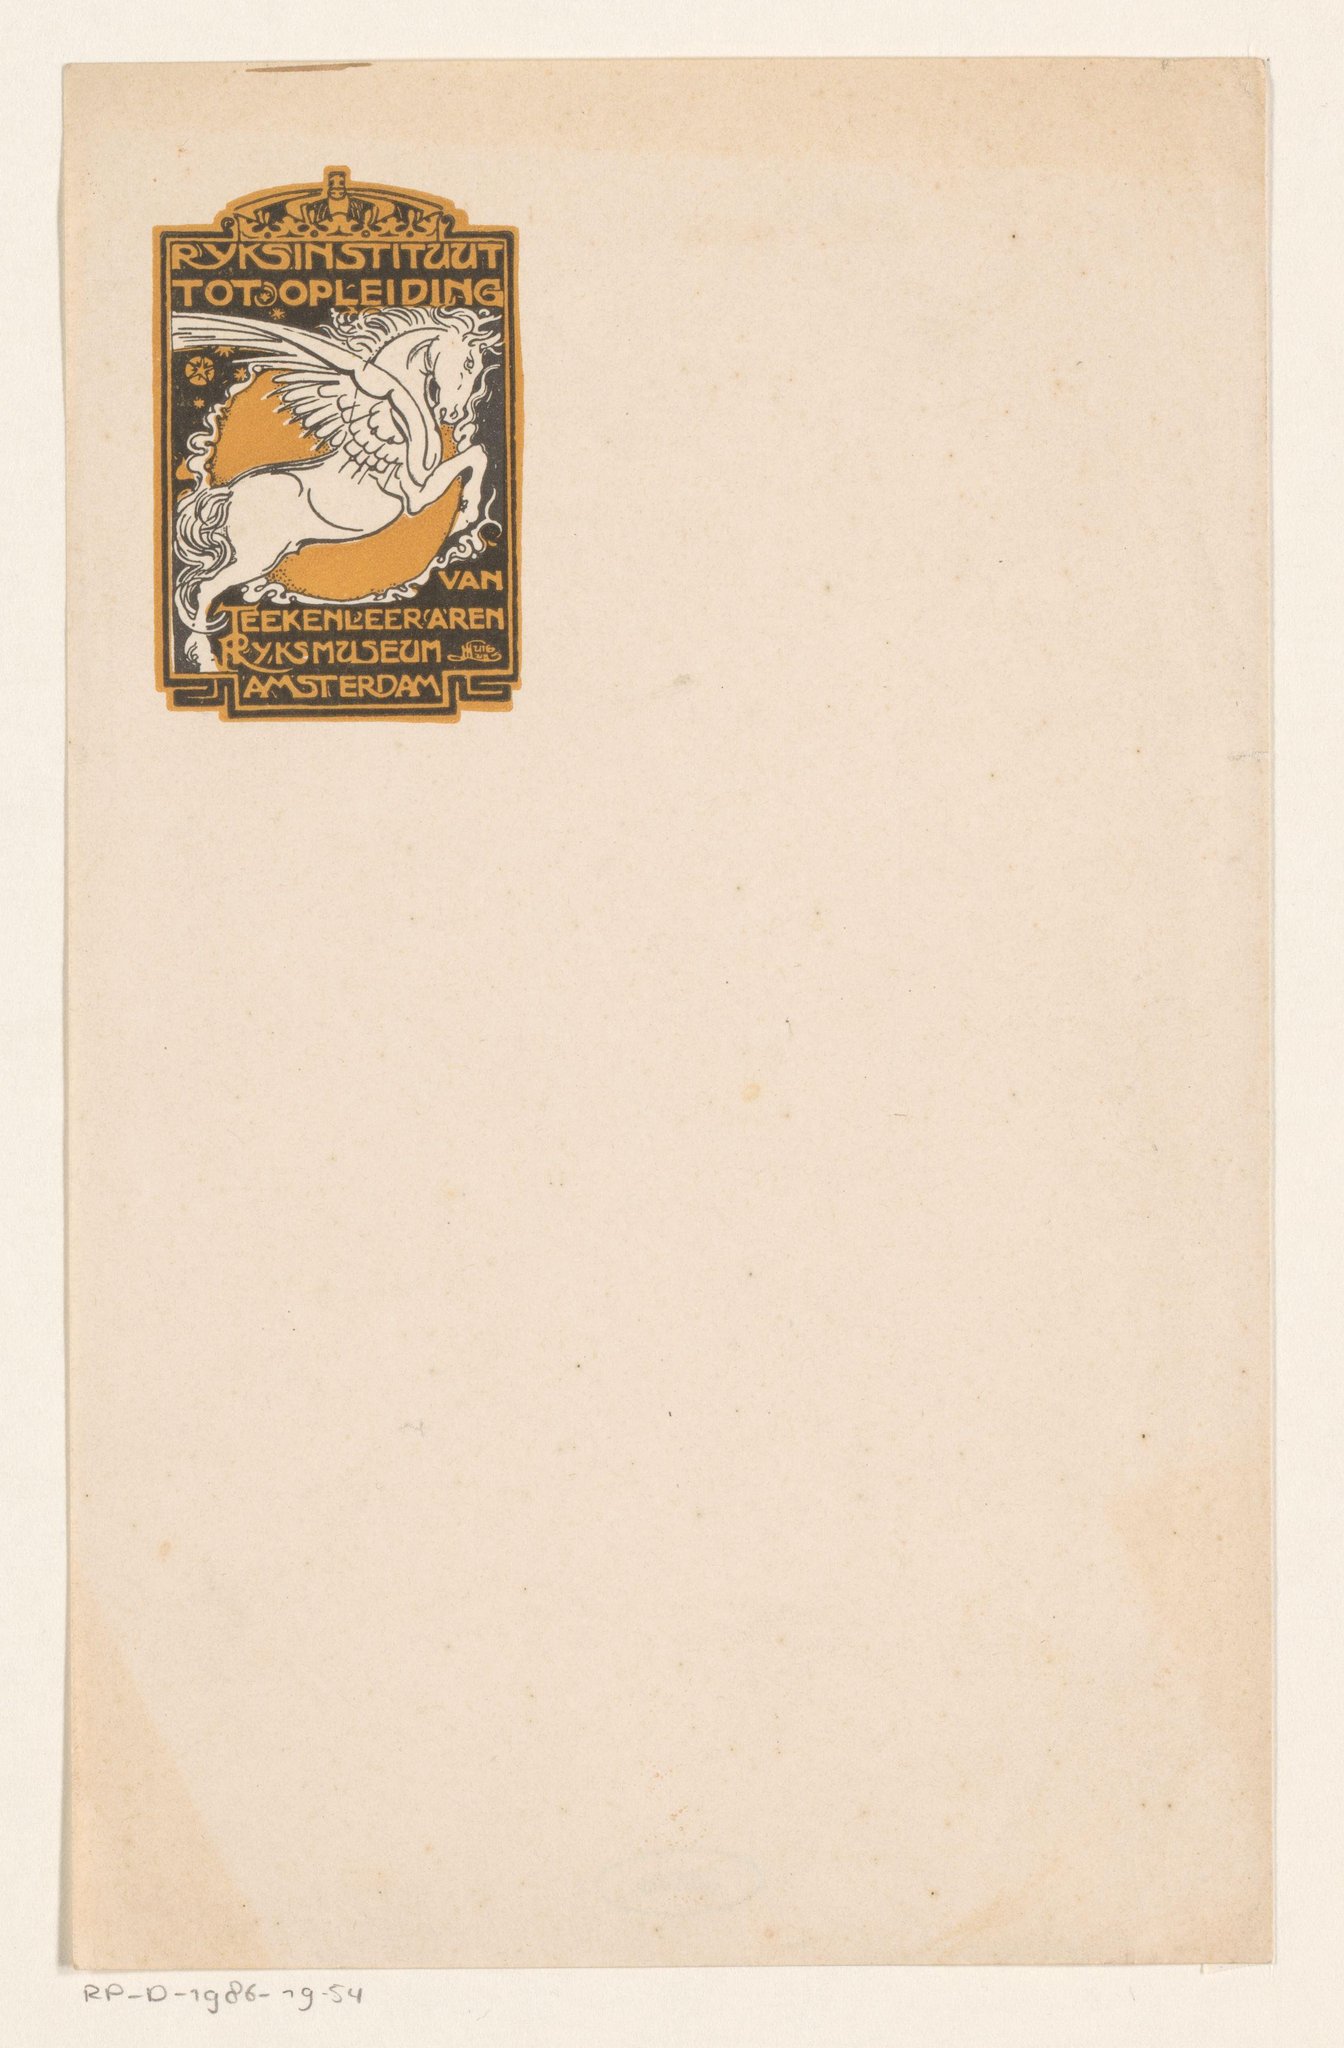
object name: print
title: Briefpapier van het Rijksinstituut tot Opleiding van Tekenleraren te Amsterdam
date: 1923-1970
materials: paper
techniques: relief print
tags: fabulous animals ~ hoofed animals: winged horse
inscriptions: collector's mark: ‘R:MVS.’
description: Rechthoekig kader met daarin een cirkel met een gevleugeld paard.